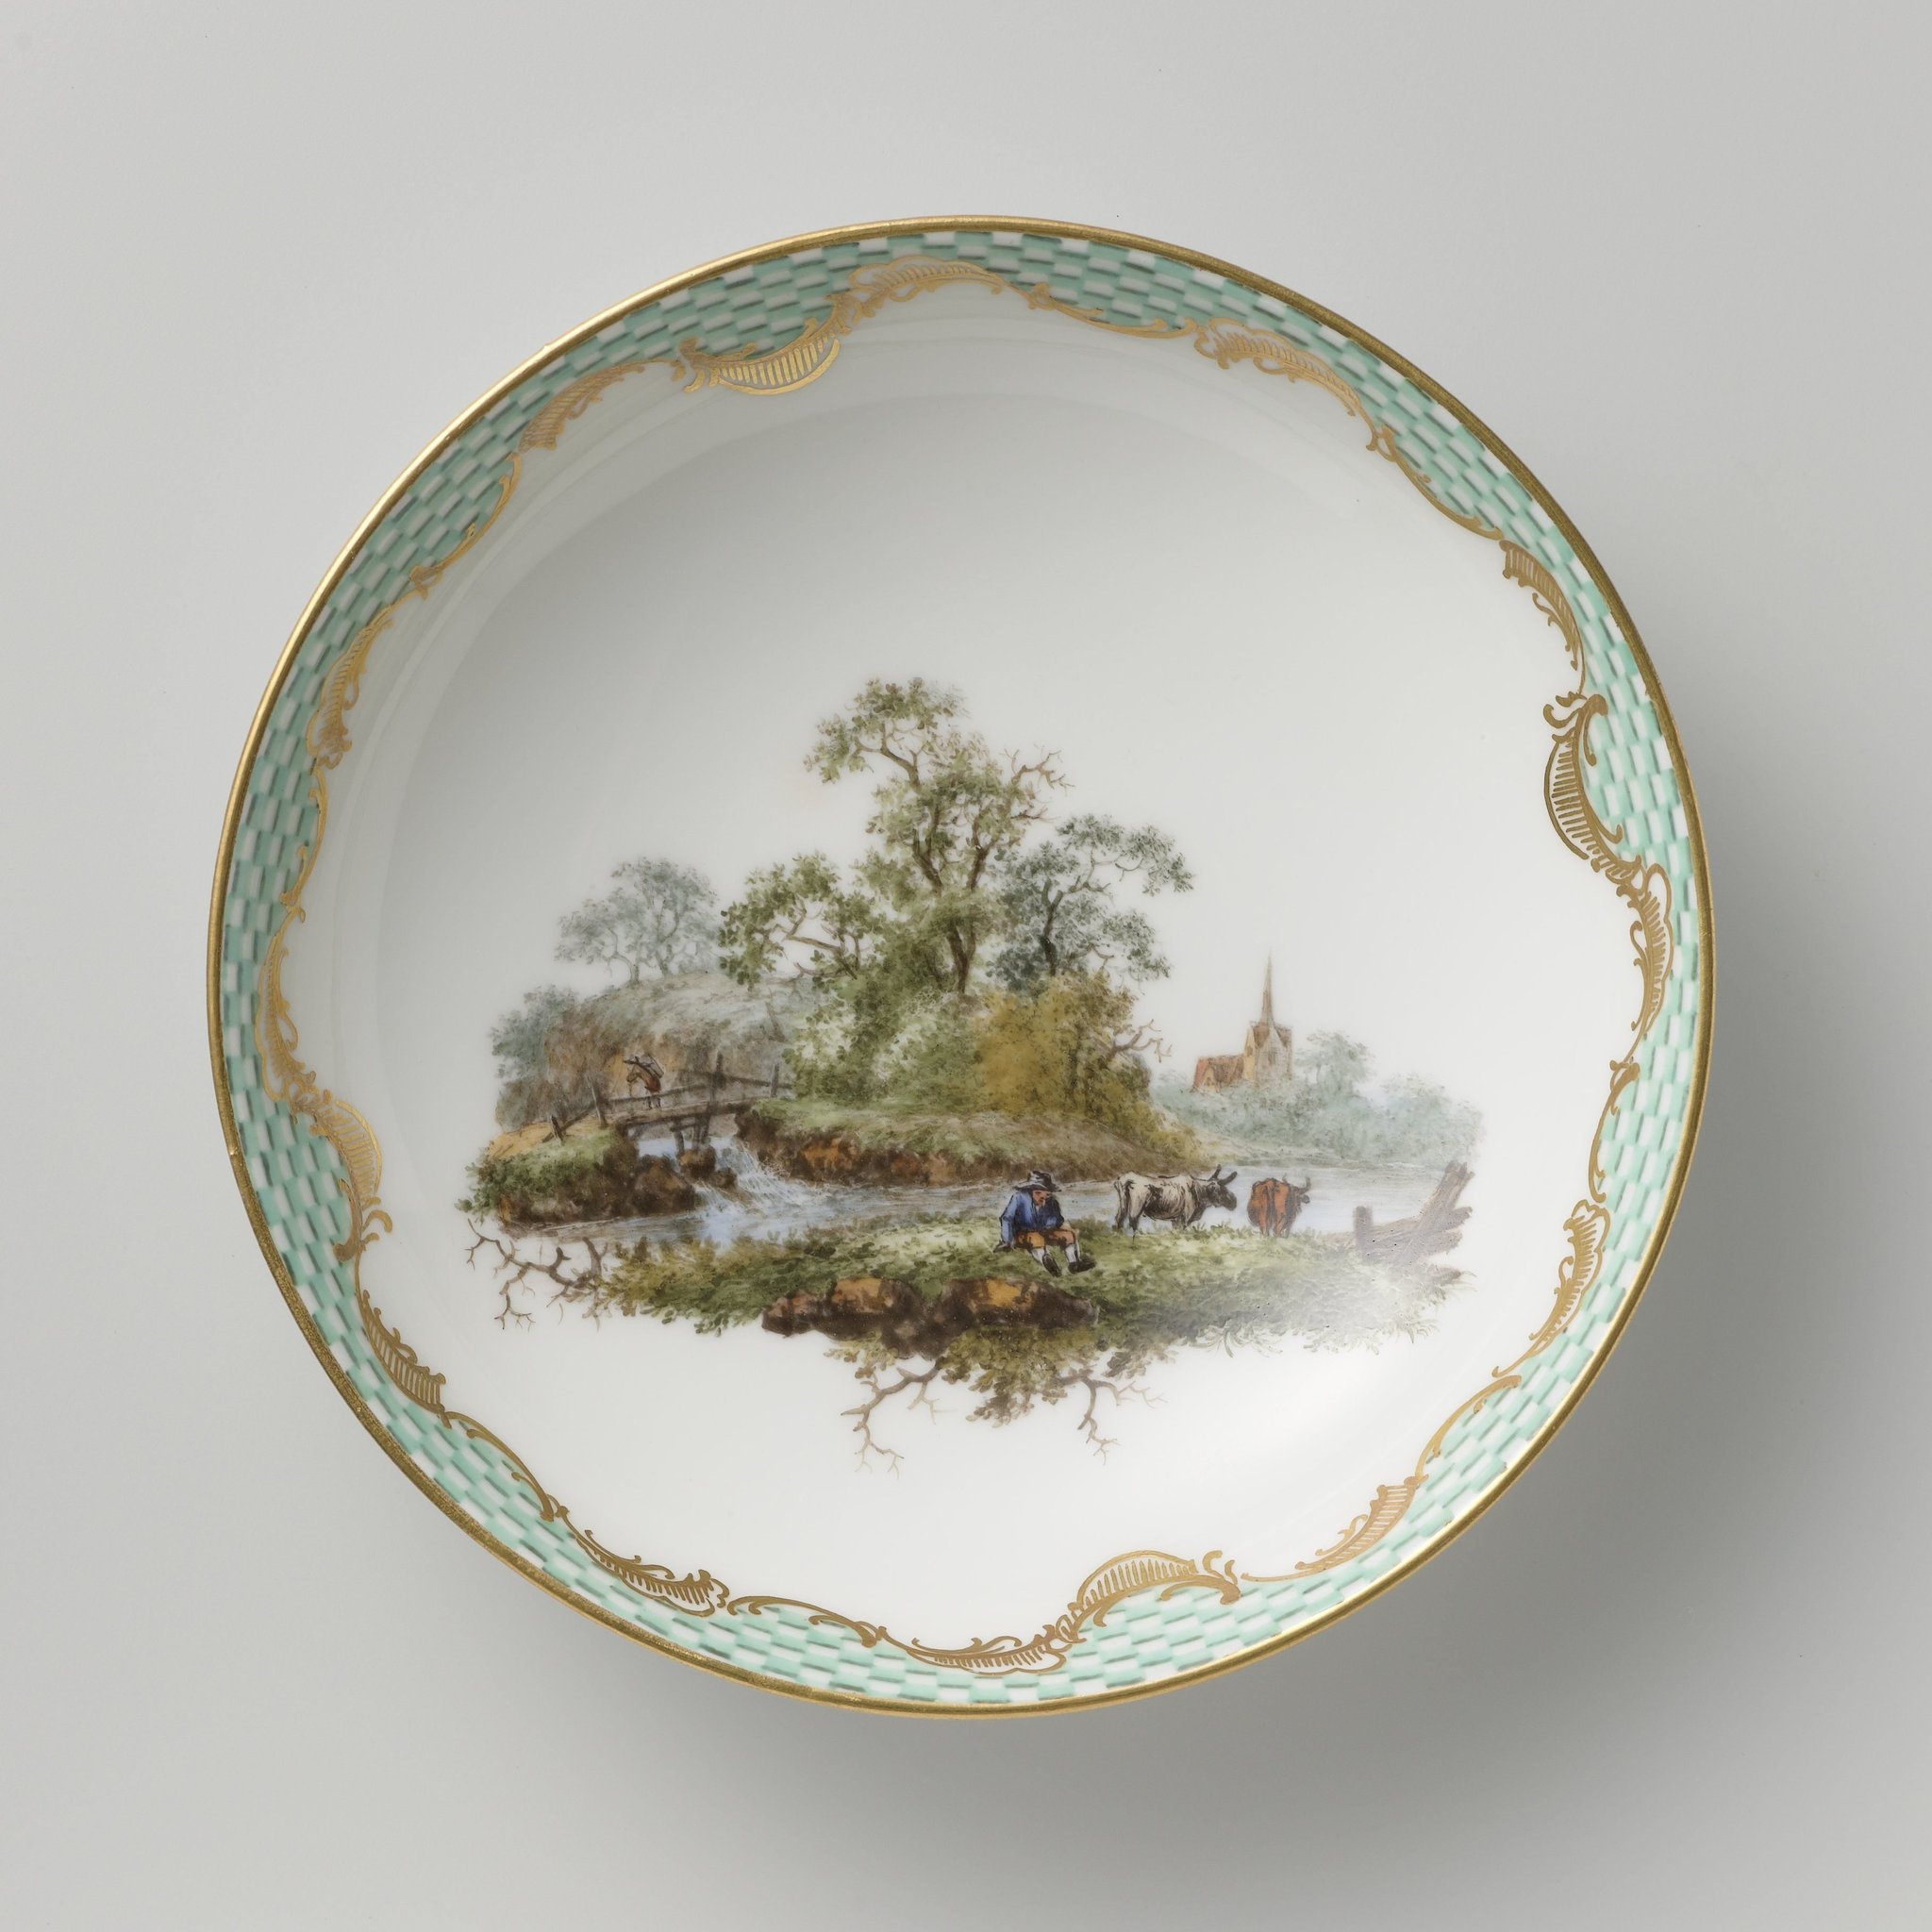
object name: eating drinking utensil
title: Schotel, veelkleurig beschilderd met een landschap met figuren.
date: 1777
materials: porcelain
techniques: painted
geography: meissen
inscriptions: mold mark, factory mark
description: Ronde schotel van beschilderd porselein. De schotel is beschilderd met landschappen waarin figuren en langs de rand een brede strook groen vlechtwerk. De schotel is gemerkt.